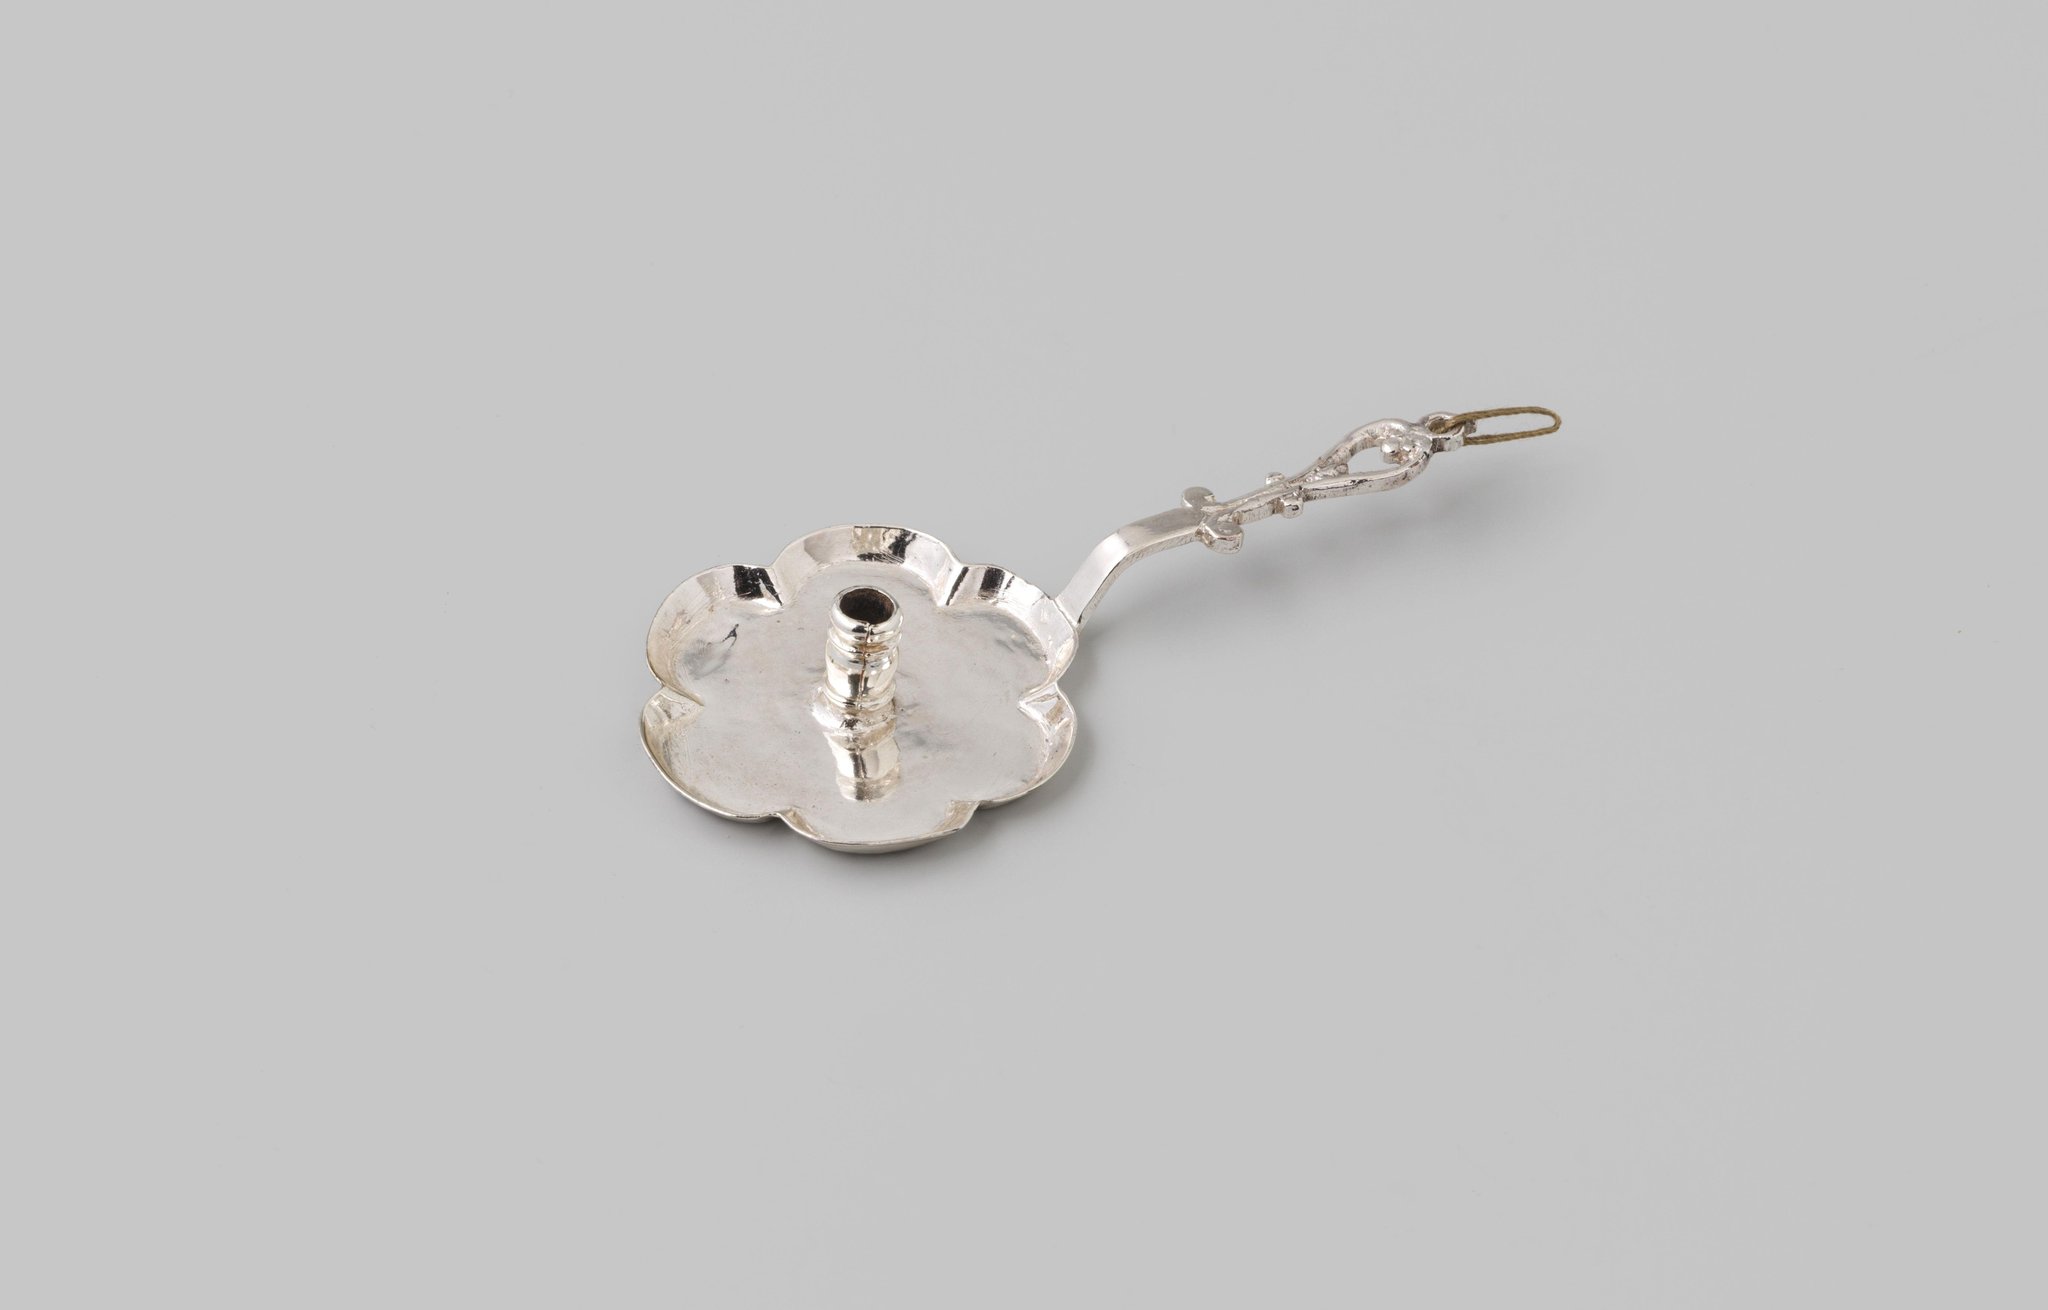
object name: miniature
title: Steelblaker van zilver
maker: michiel maenbeeck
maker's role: silversmith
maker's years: 1634-1682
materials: silver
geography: haarlem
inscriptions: maker's mark: ‘wassende maan (Citroen 1975, nr. 1166)’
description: Steelblaker van zilver met opengewerkt handvat, zeslobbige gladde vetvanger met gedraaide kaarsenhouder.